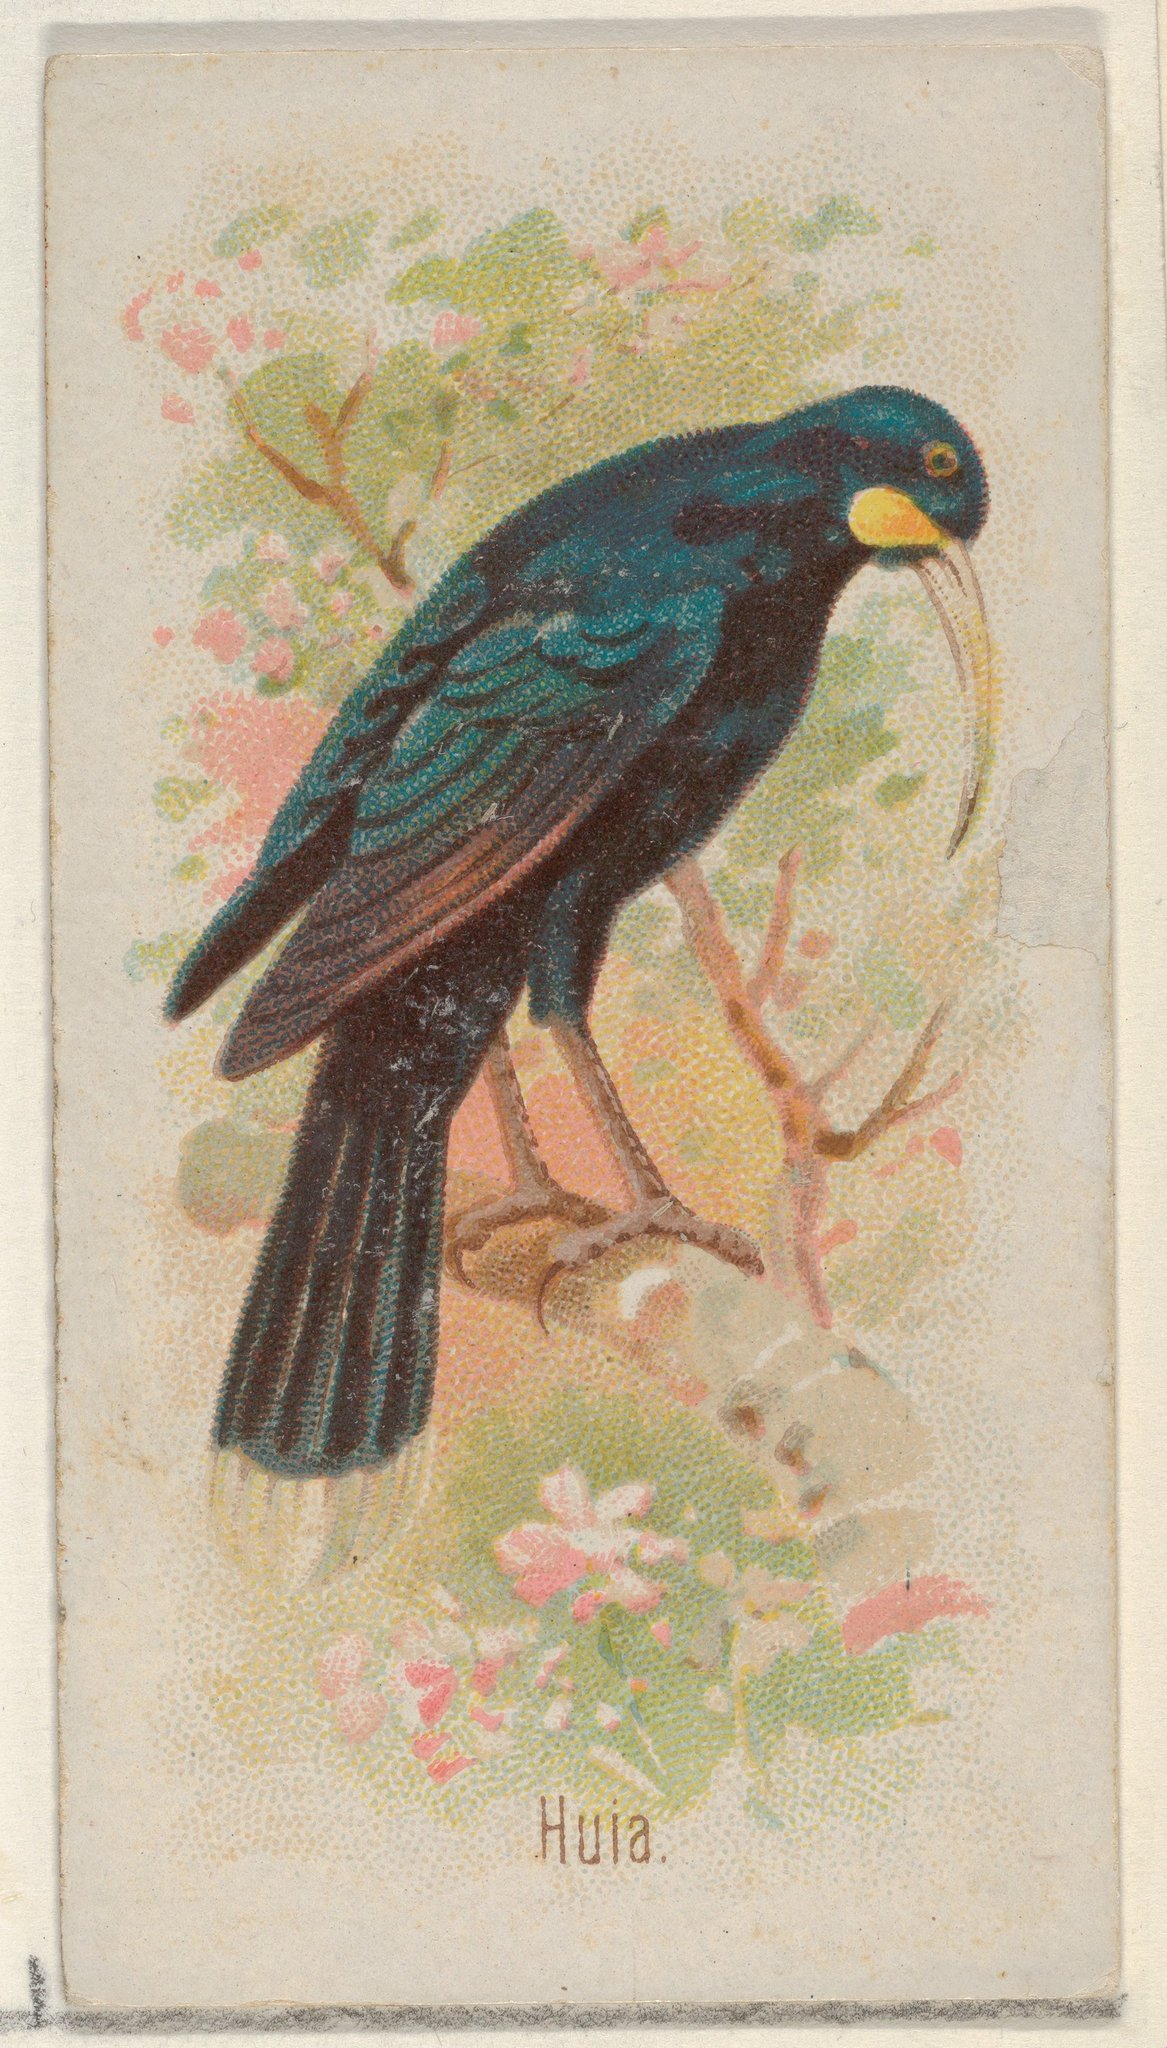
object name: print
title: Huia, from the Song Birds of the World series (N23) for Allen & Ginter Cigarettes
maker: allen & ginter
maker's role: publisher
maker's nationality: american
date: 1890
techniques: color lithograph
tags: birds